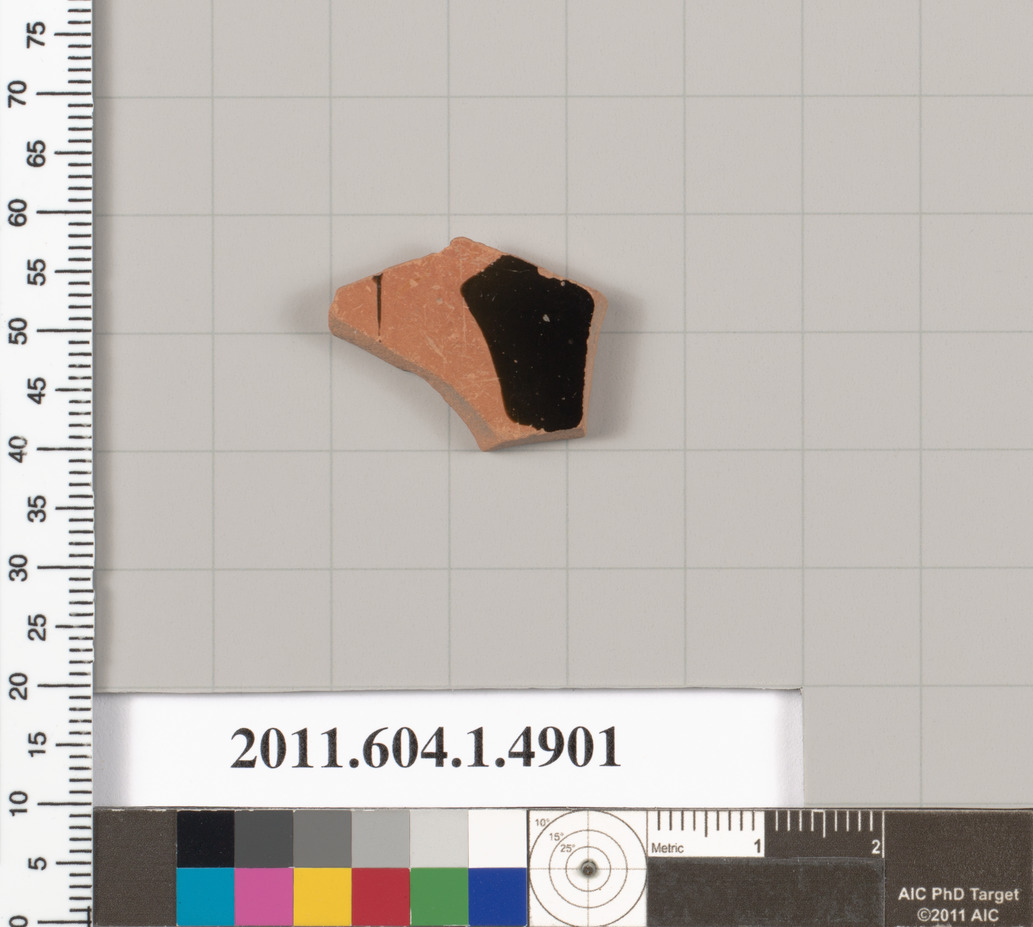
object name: kylix fragment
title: Terracotta fragment of a kylix (drinking cup)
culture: greek, attic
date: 500-476 BCE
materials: terracotta